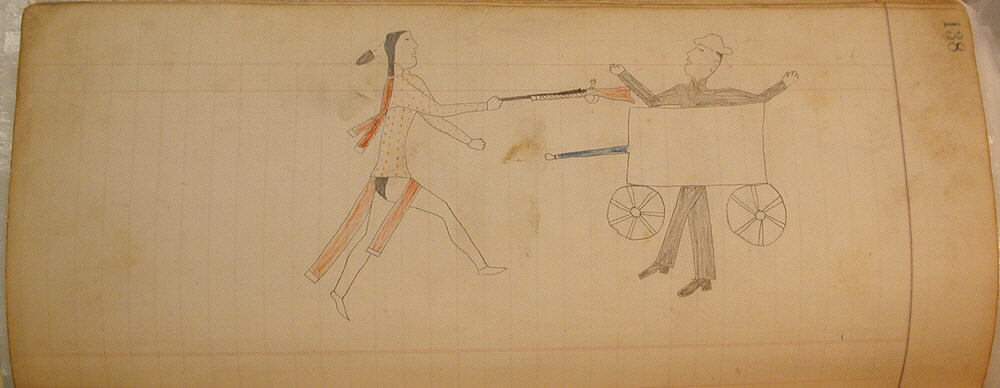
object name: drawing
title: Maffet Ledger: Drawing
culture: cheyenne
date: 1874-1881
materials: crayon, graphite, paper, watercolor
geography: united states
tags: men,women